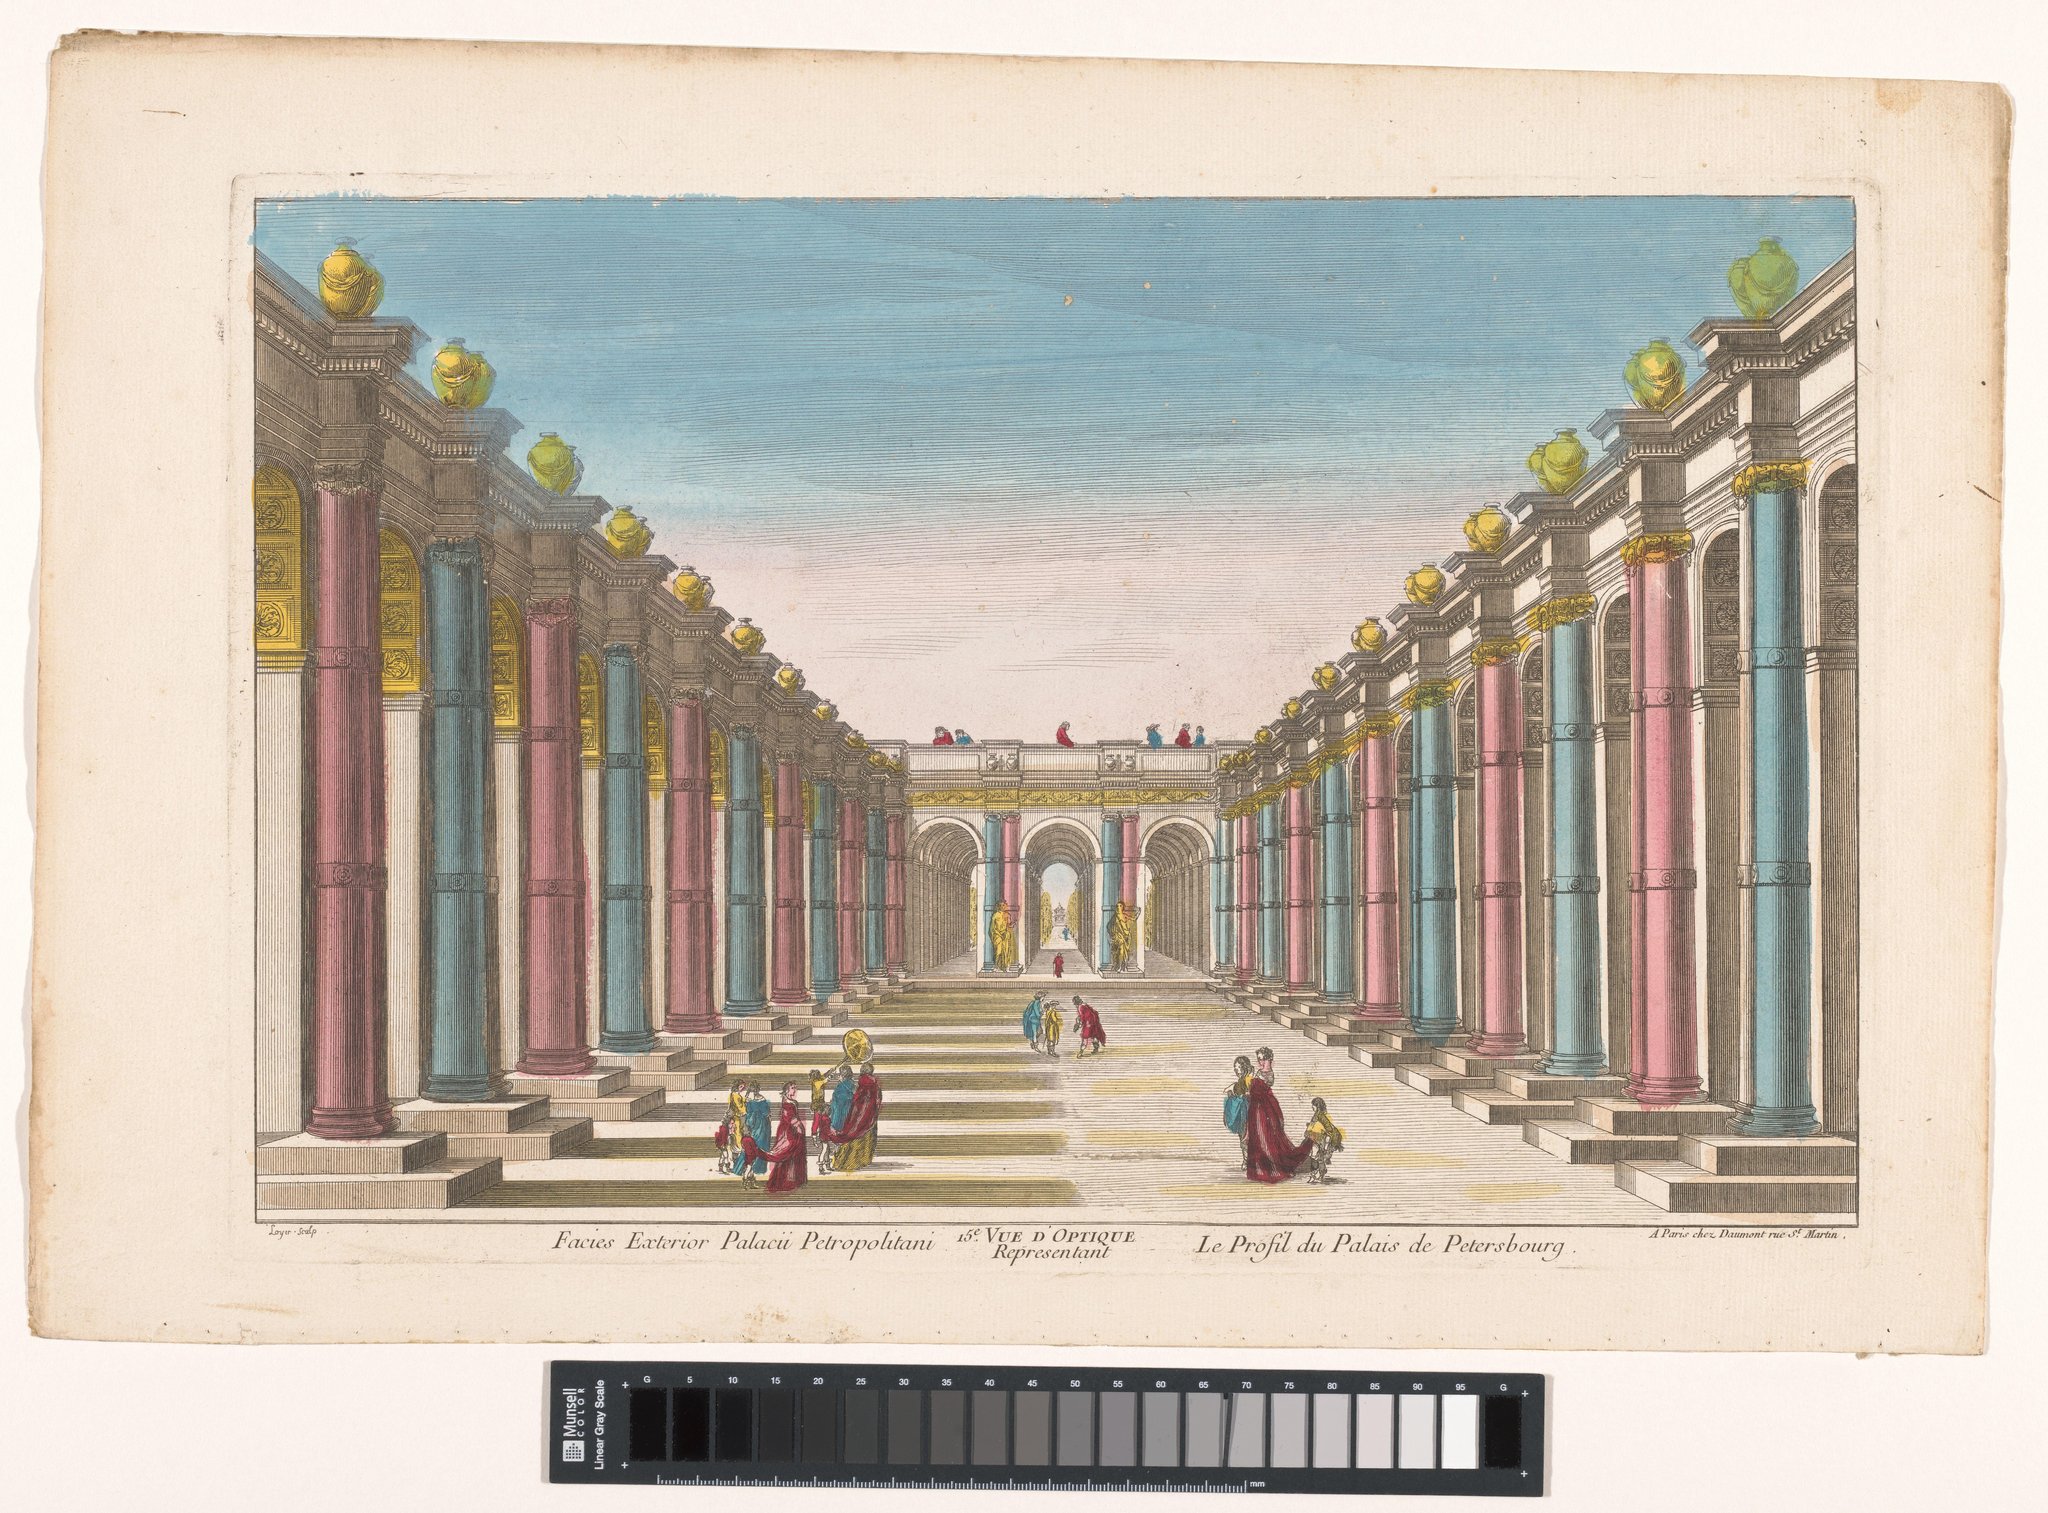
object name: opticaprent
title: 15e. Vue d'optique representant le profil du palais de Petersbourg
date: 1745-1775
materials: paper, watercolor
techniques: brush, etching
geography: paris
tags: colonnade, palace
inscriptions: collector's mark: Lugt 2166, watermark